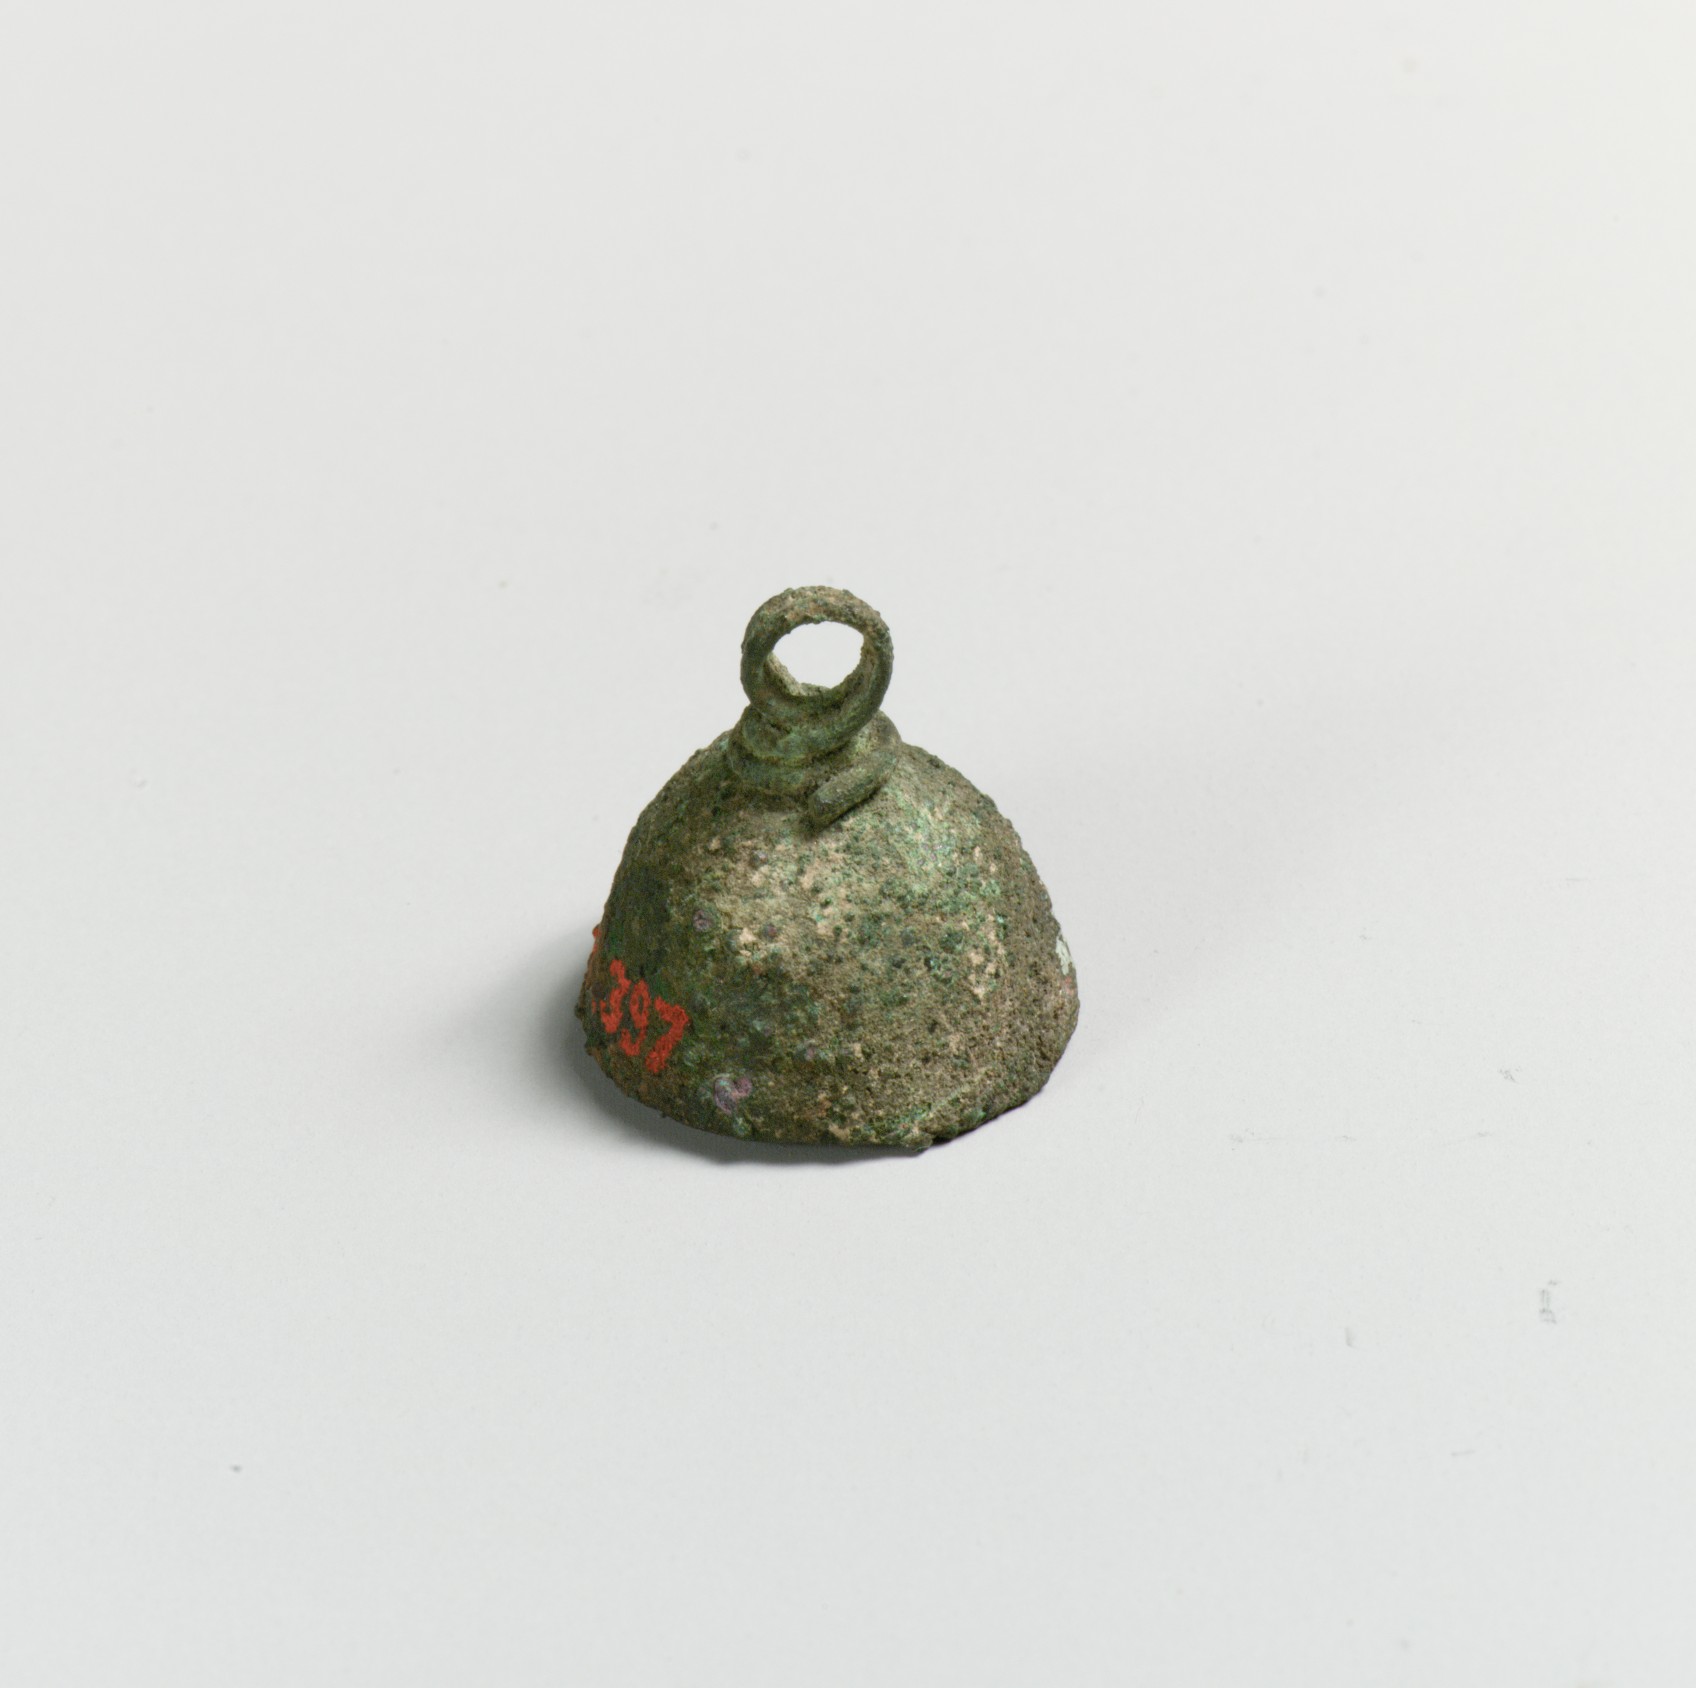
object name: bell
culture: cypriot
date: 400-301 BCE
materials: bronze